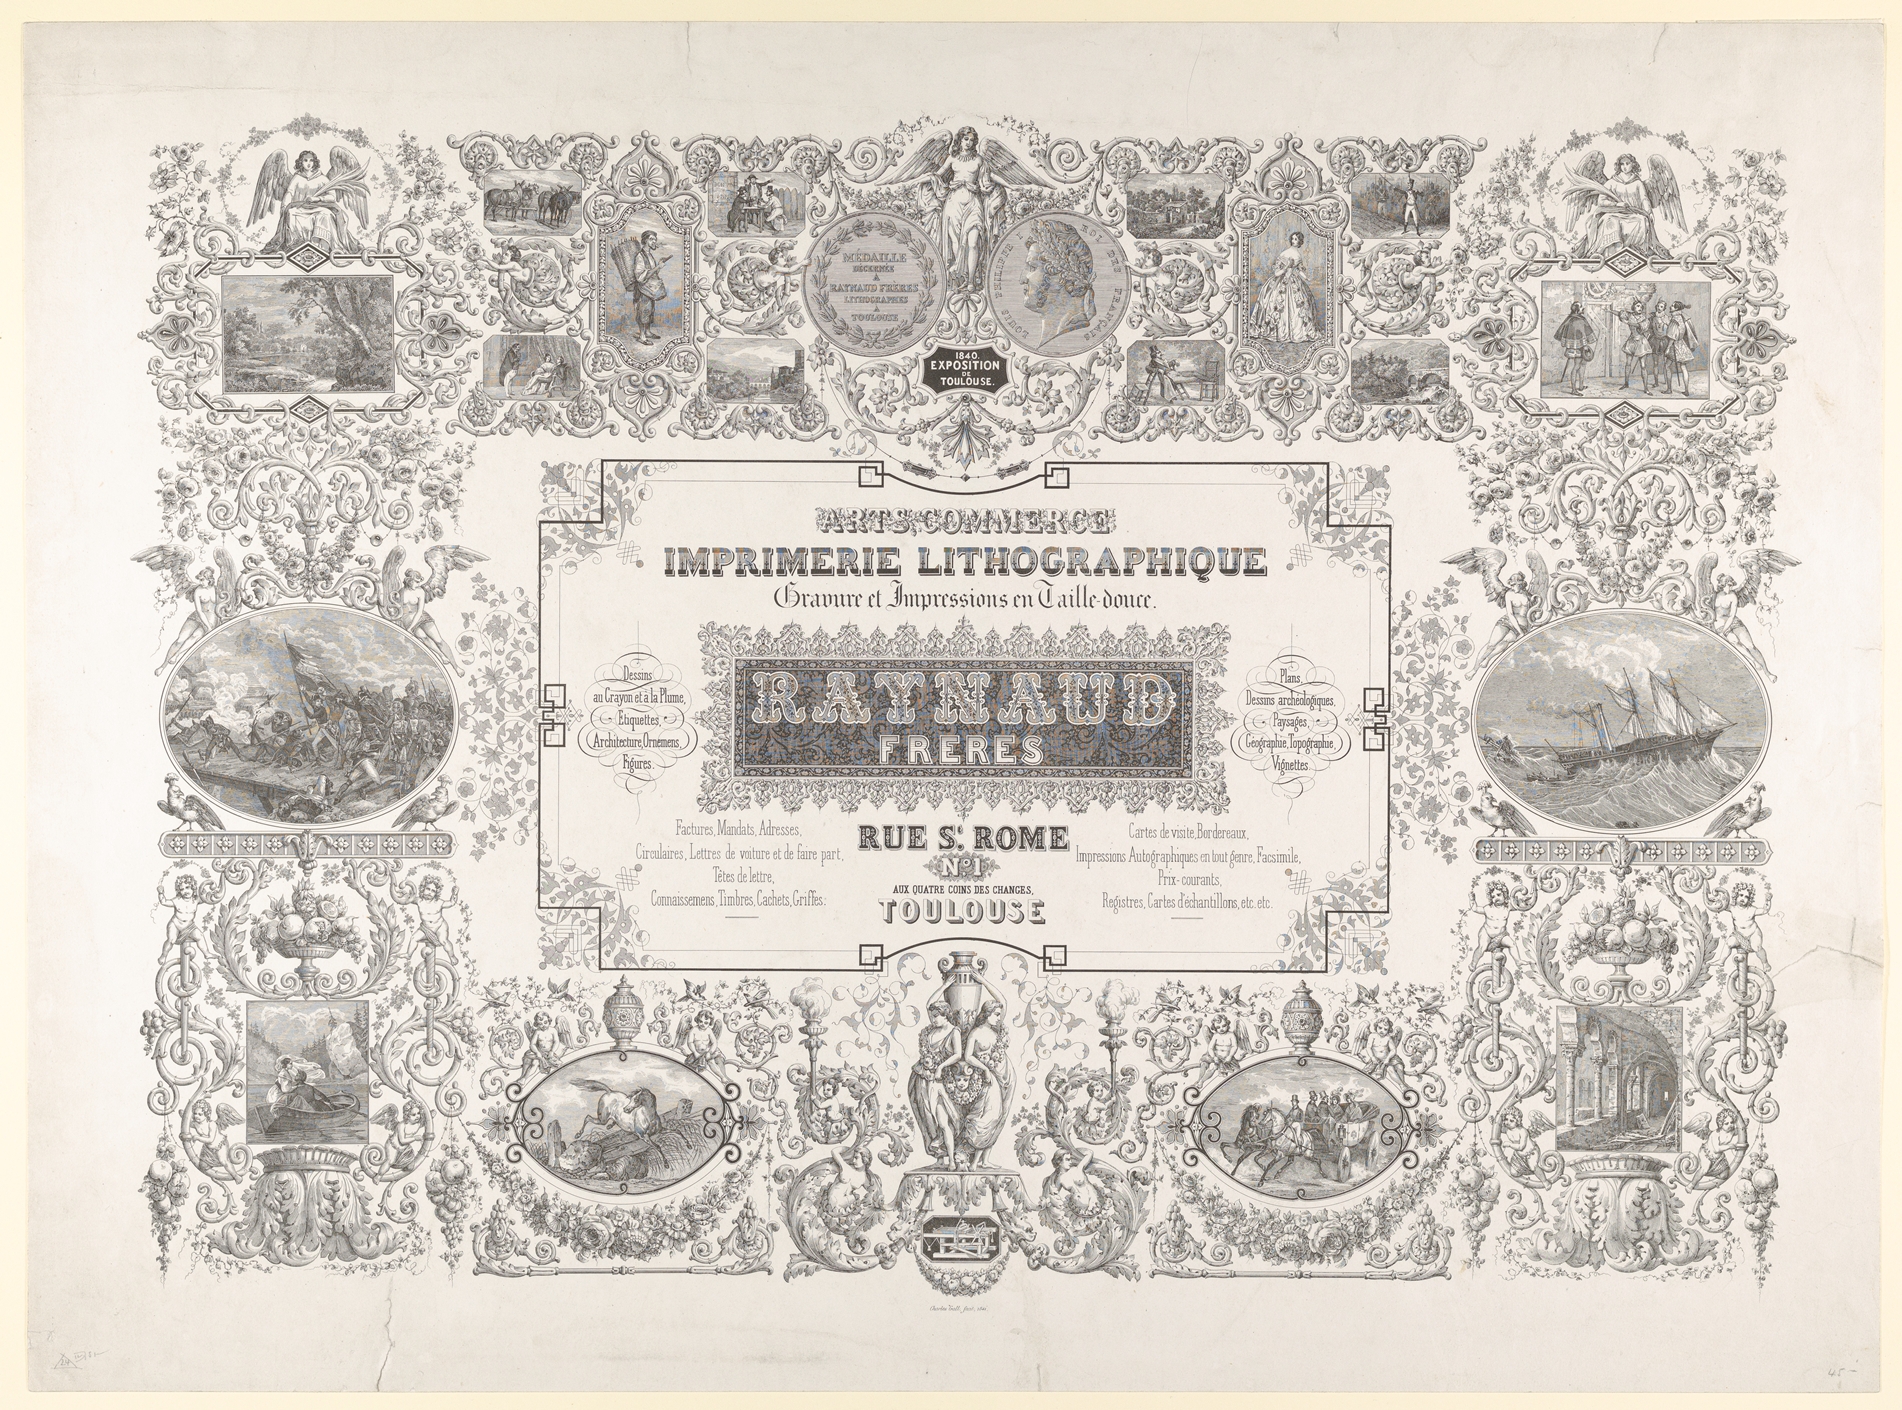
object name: poster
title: Poster for Raynaud Frères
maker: Anonymous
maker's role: artist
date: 1841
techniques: lithograph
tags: horses,ships